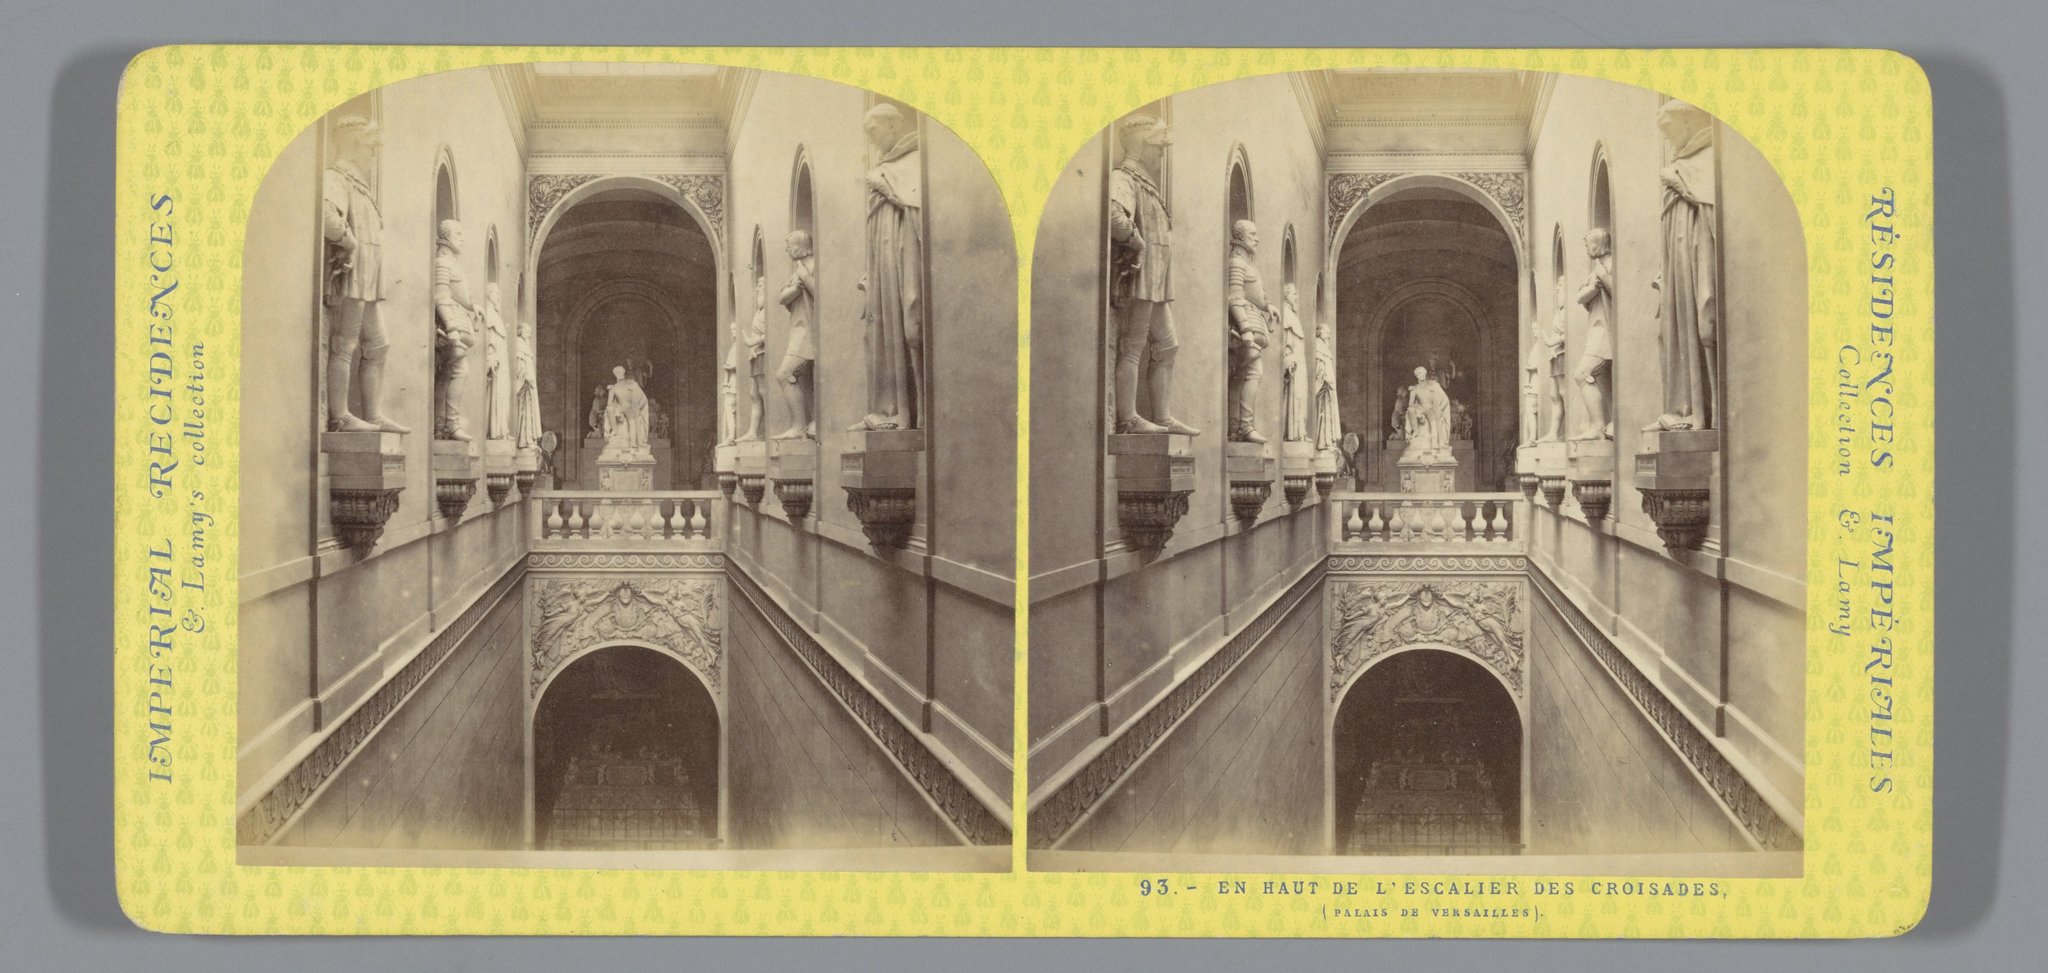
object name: stereograph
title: Imperial Residences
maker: ernest eléonor pierre lamy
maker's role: publisher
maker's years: 1828-1900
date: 1860-1880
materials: cardboard, photographic support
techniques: albumen print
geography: versailles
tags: staircase, sculpture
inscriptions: inscription: ‘E. Lamy's collection’, number: ‘93.’